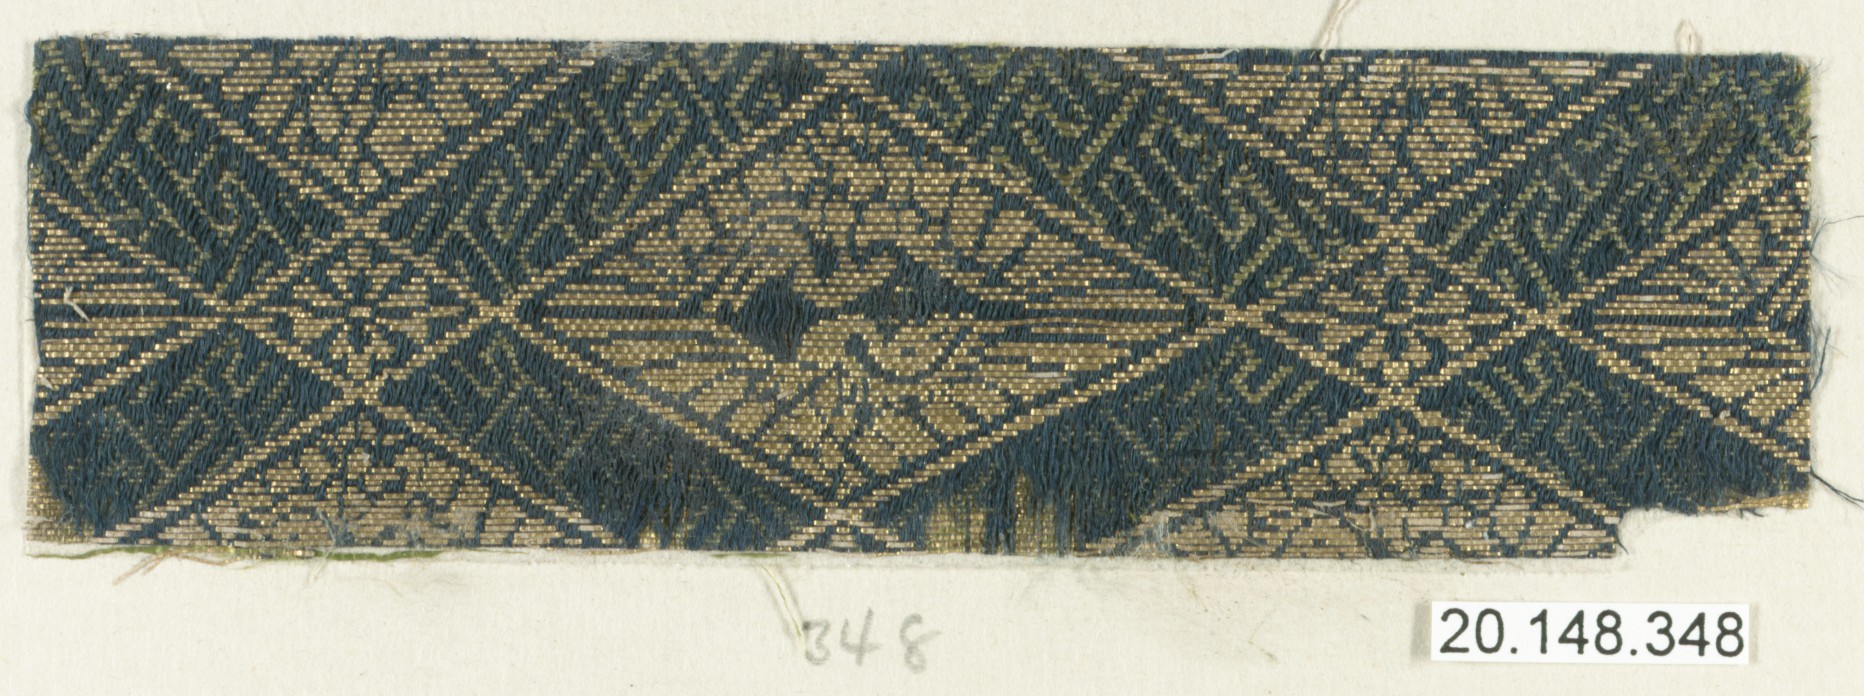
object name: piece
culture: japanese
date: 1701-1800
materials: silk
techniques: compound weave